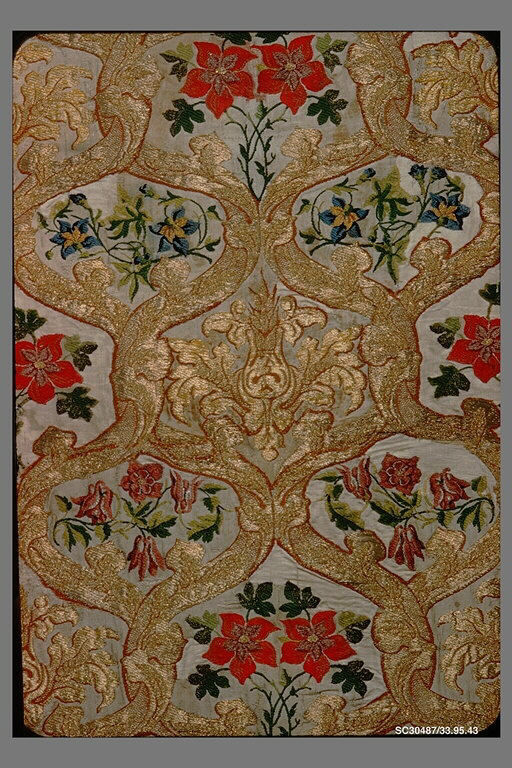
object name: fragment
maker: prof. rössner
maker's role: designer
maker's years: 1800-1900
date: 1841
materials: metal thread, silk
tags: flowers,leaves